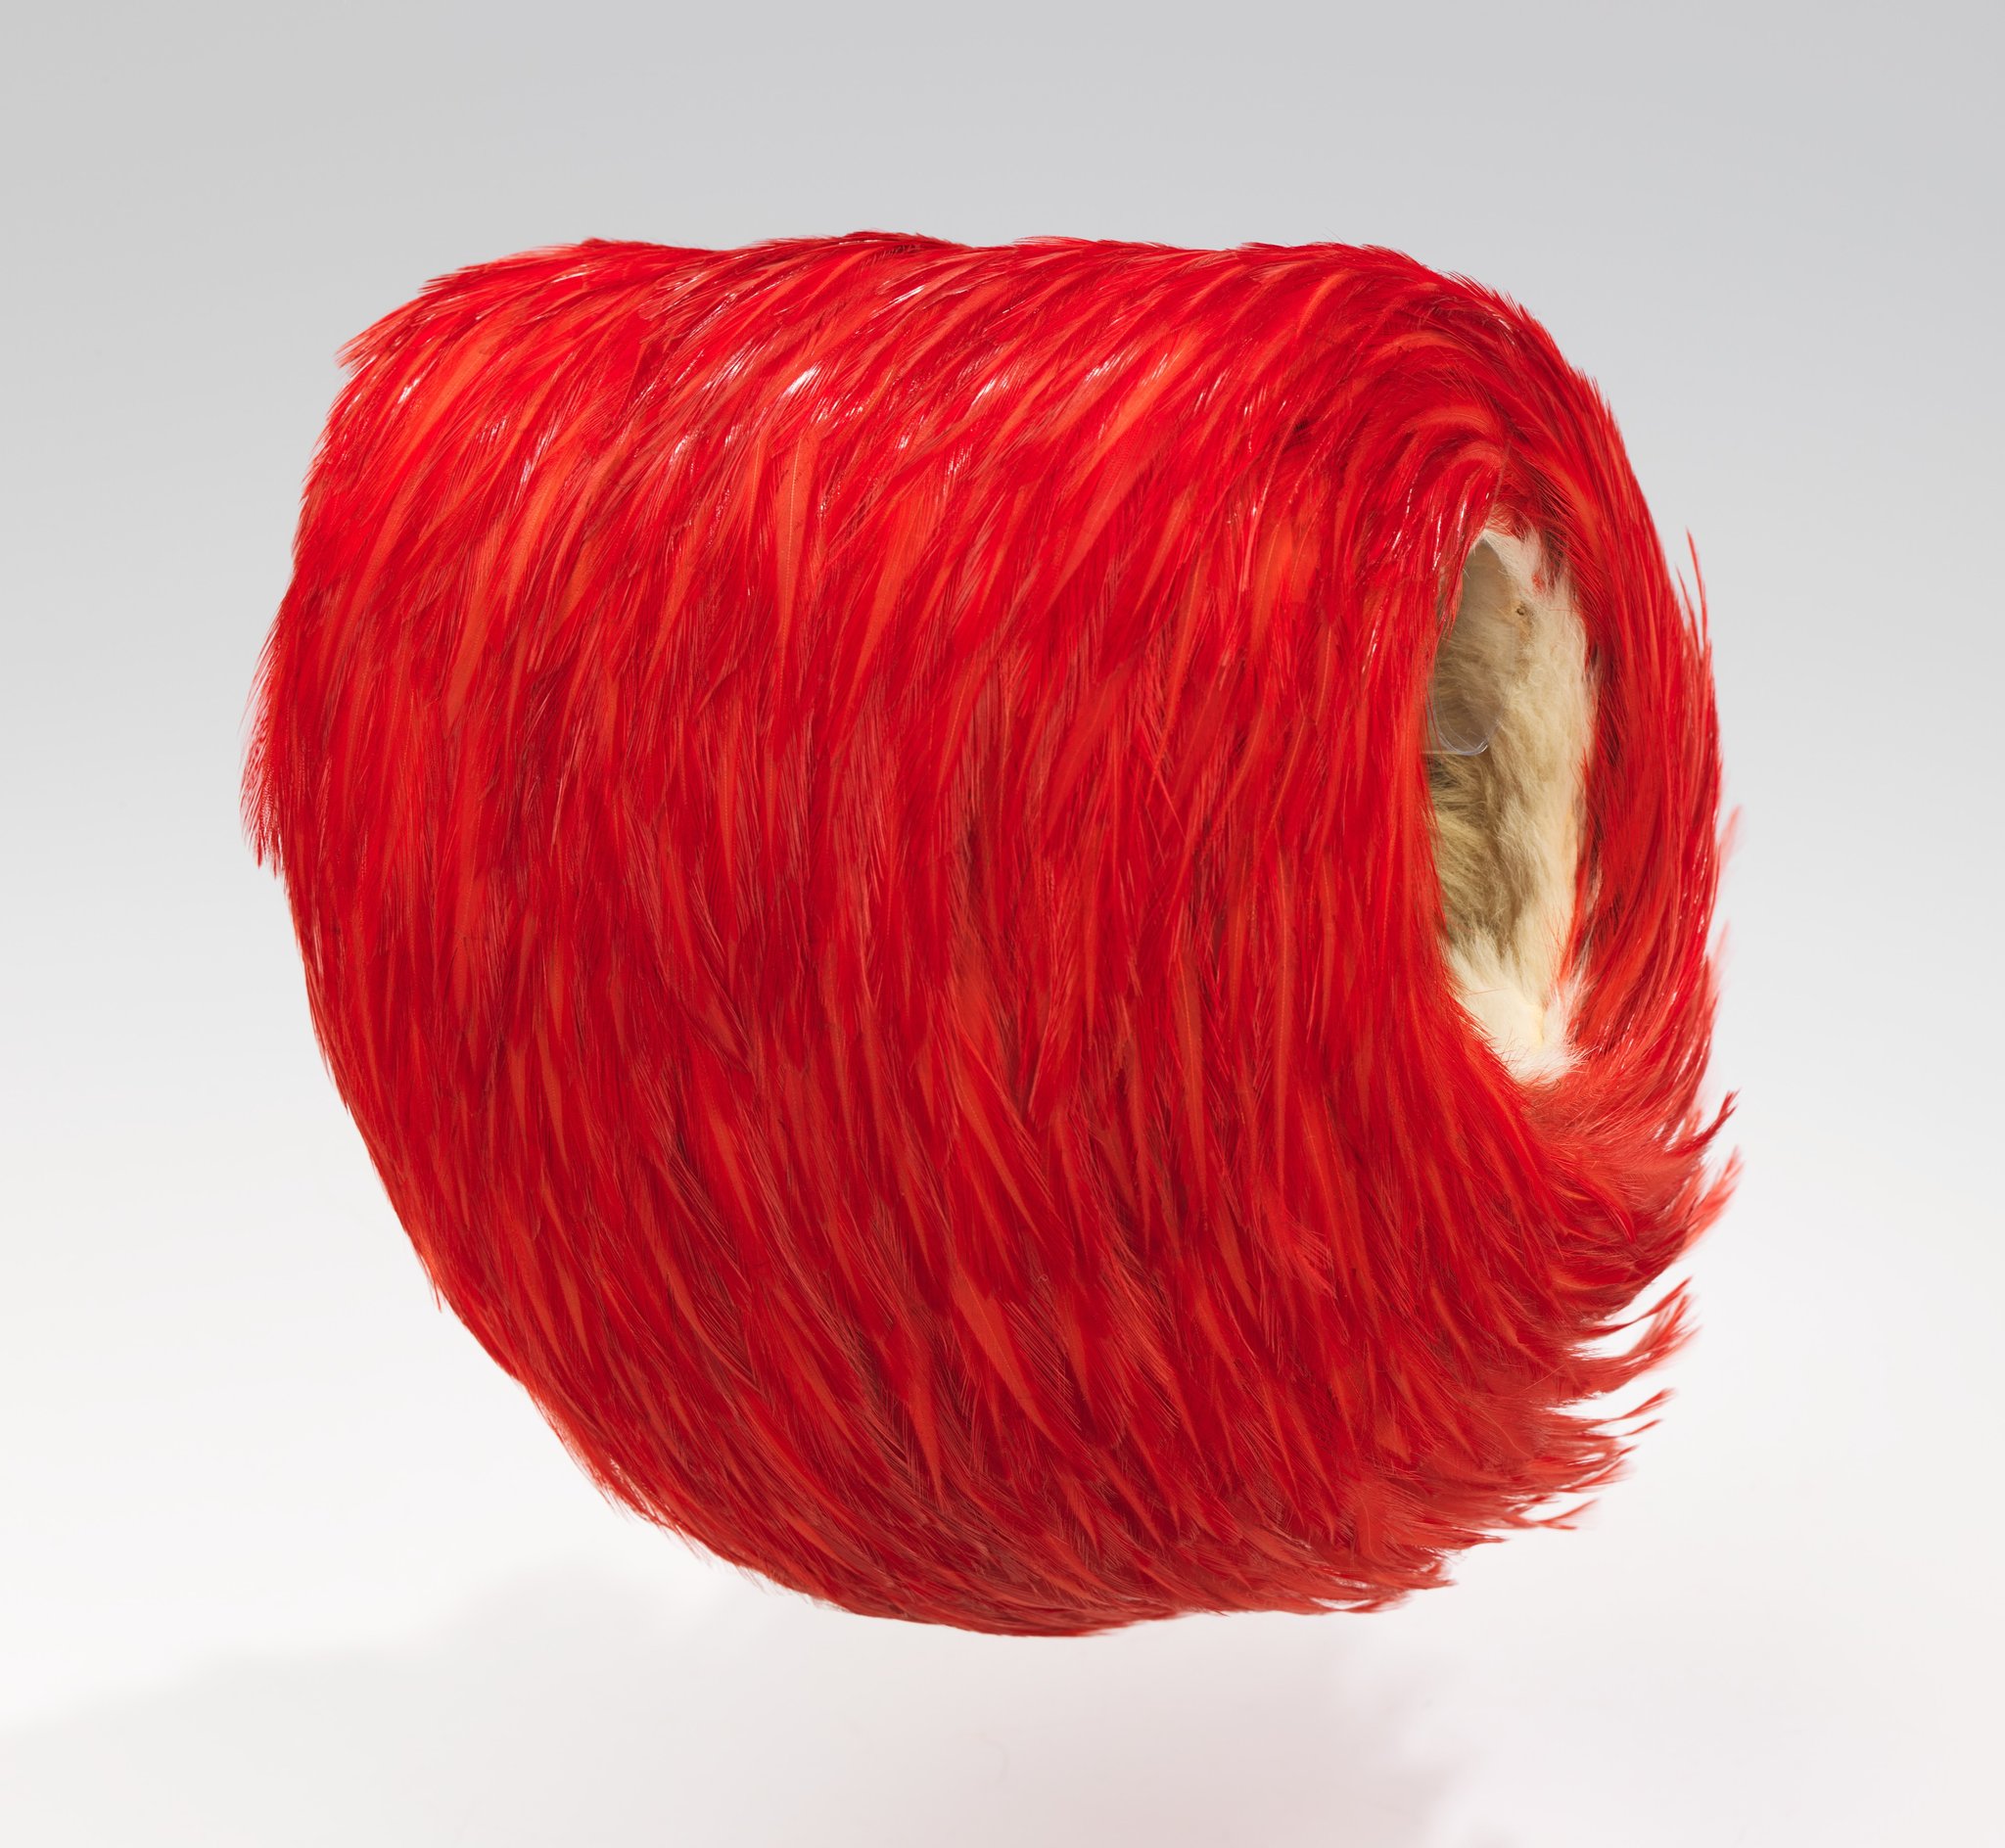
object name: muff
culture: french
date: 1801-1833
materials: feather, wool